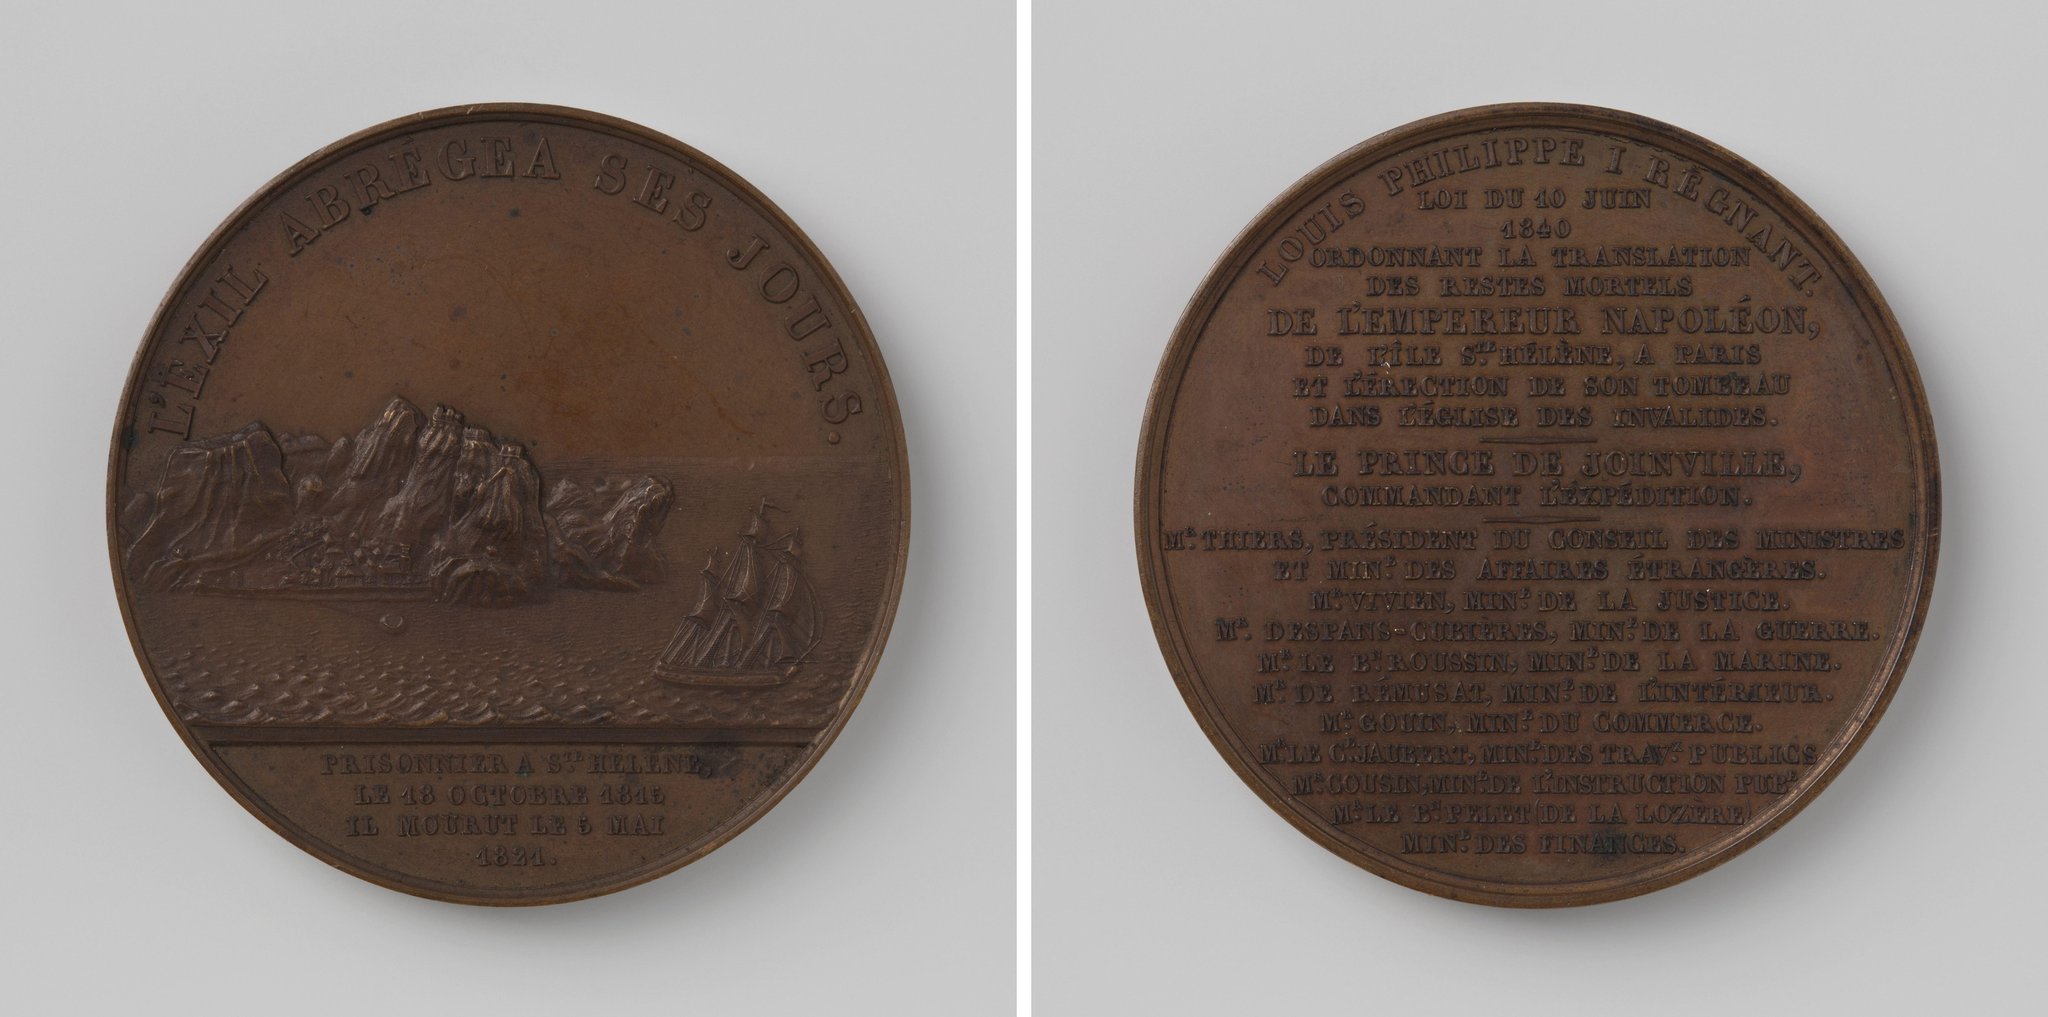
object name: history medal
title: Overbrenging van het lijk van Napoleon Bonaparte van St. Helena naar Frankrijk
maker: Anonymous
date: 1840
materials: bronze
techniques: striking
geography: paris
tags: marseille, politician, paris, earl, frans van orléans (prins van joinville), napoleon i (emperor of the french), lodewijk filips i (koning van frankrijk)